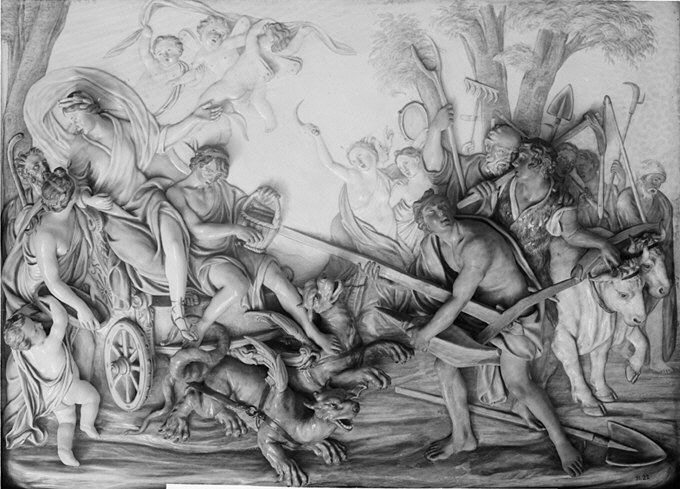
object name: plaque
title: Ceres Instructing in the Art of Husbandry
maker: doccia porcelain manufactory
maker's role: manufactory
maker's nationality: italian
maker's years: 1737-1896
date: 1801-1900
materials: porcelain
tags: men,women,dragons,putti,cows,chariots